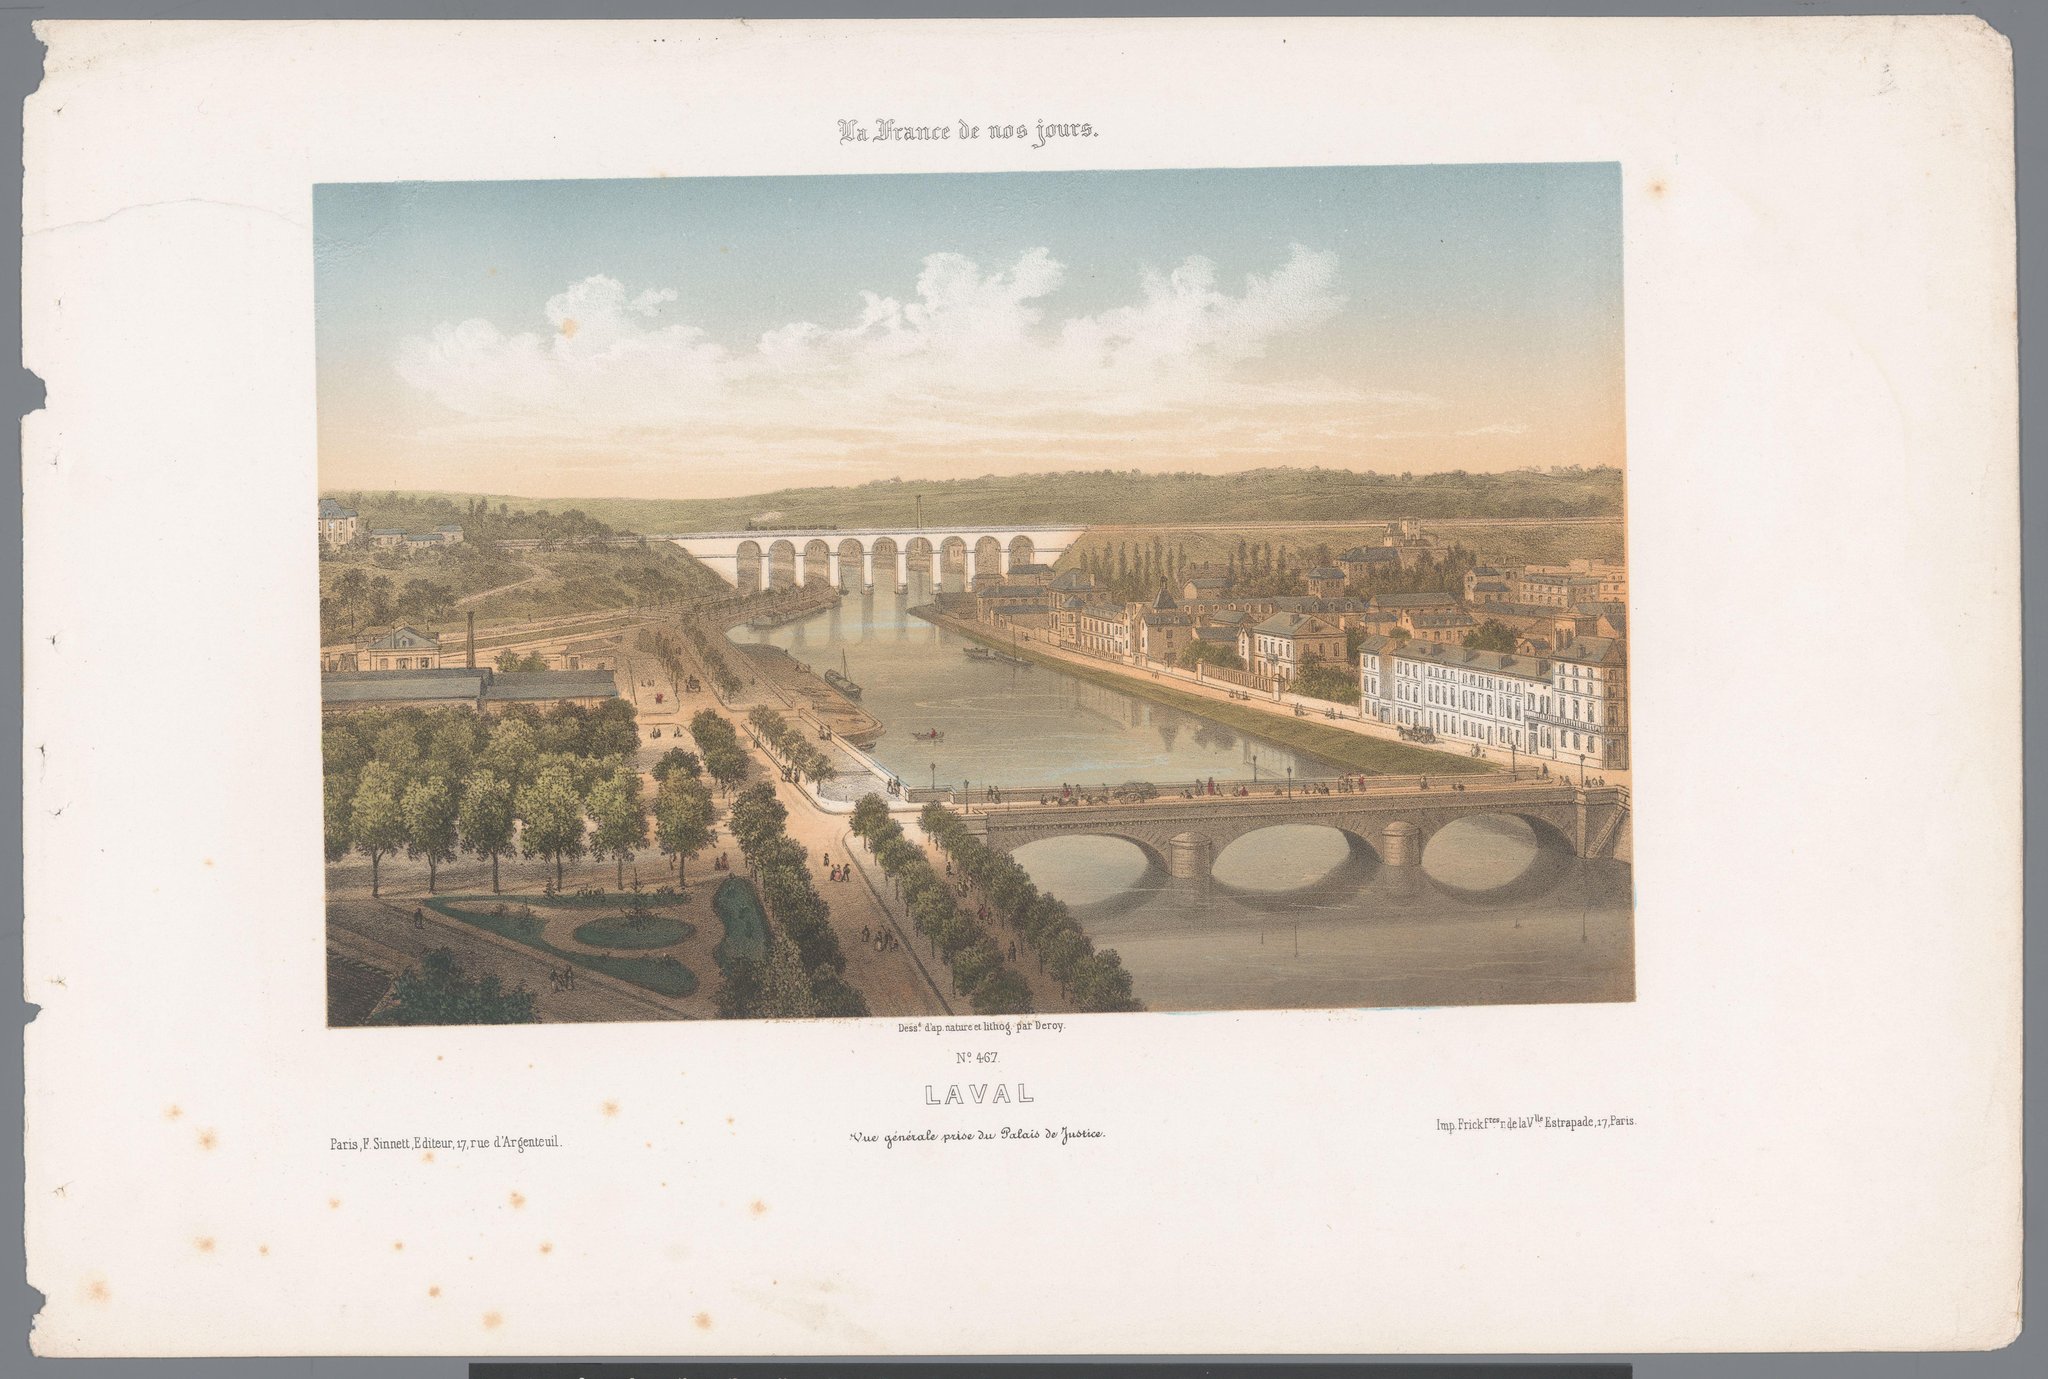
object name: print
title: Zicht op Laval vanaf het Justitiepaleis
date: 1861-1872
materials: paper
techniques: hand coloring, iris print, lithograph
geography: paris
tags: landscape with bridge, viaduct or aqueduct, bridge in city across river, canal, etc., city-view in general; 'veduta' (+ city(-scape) with figures, staffage)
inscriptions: collector's mark: Lugt 2228a